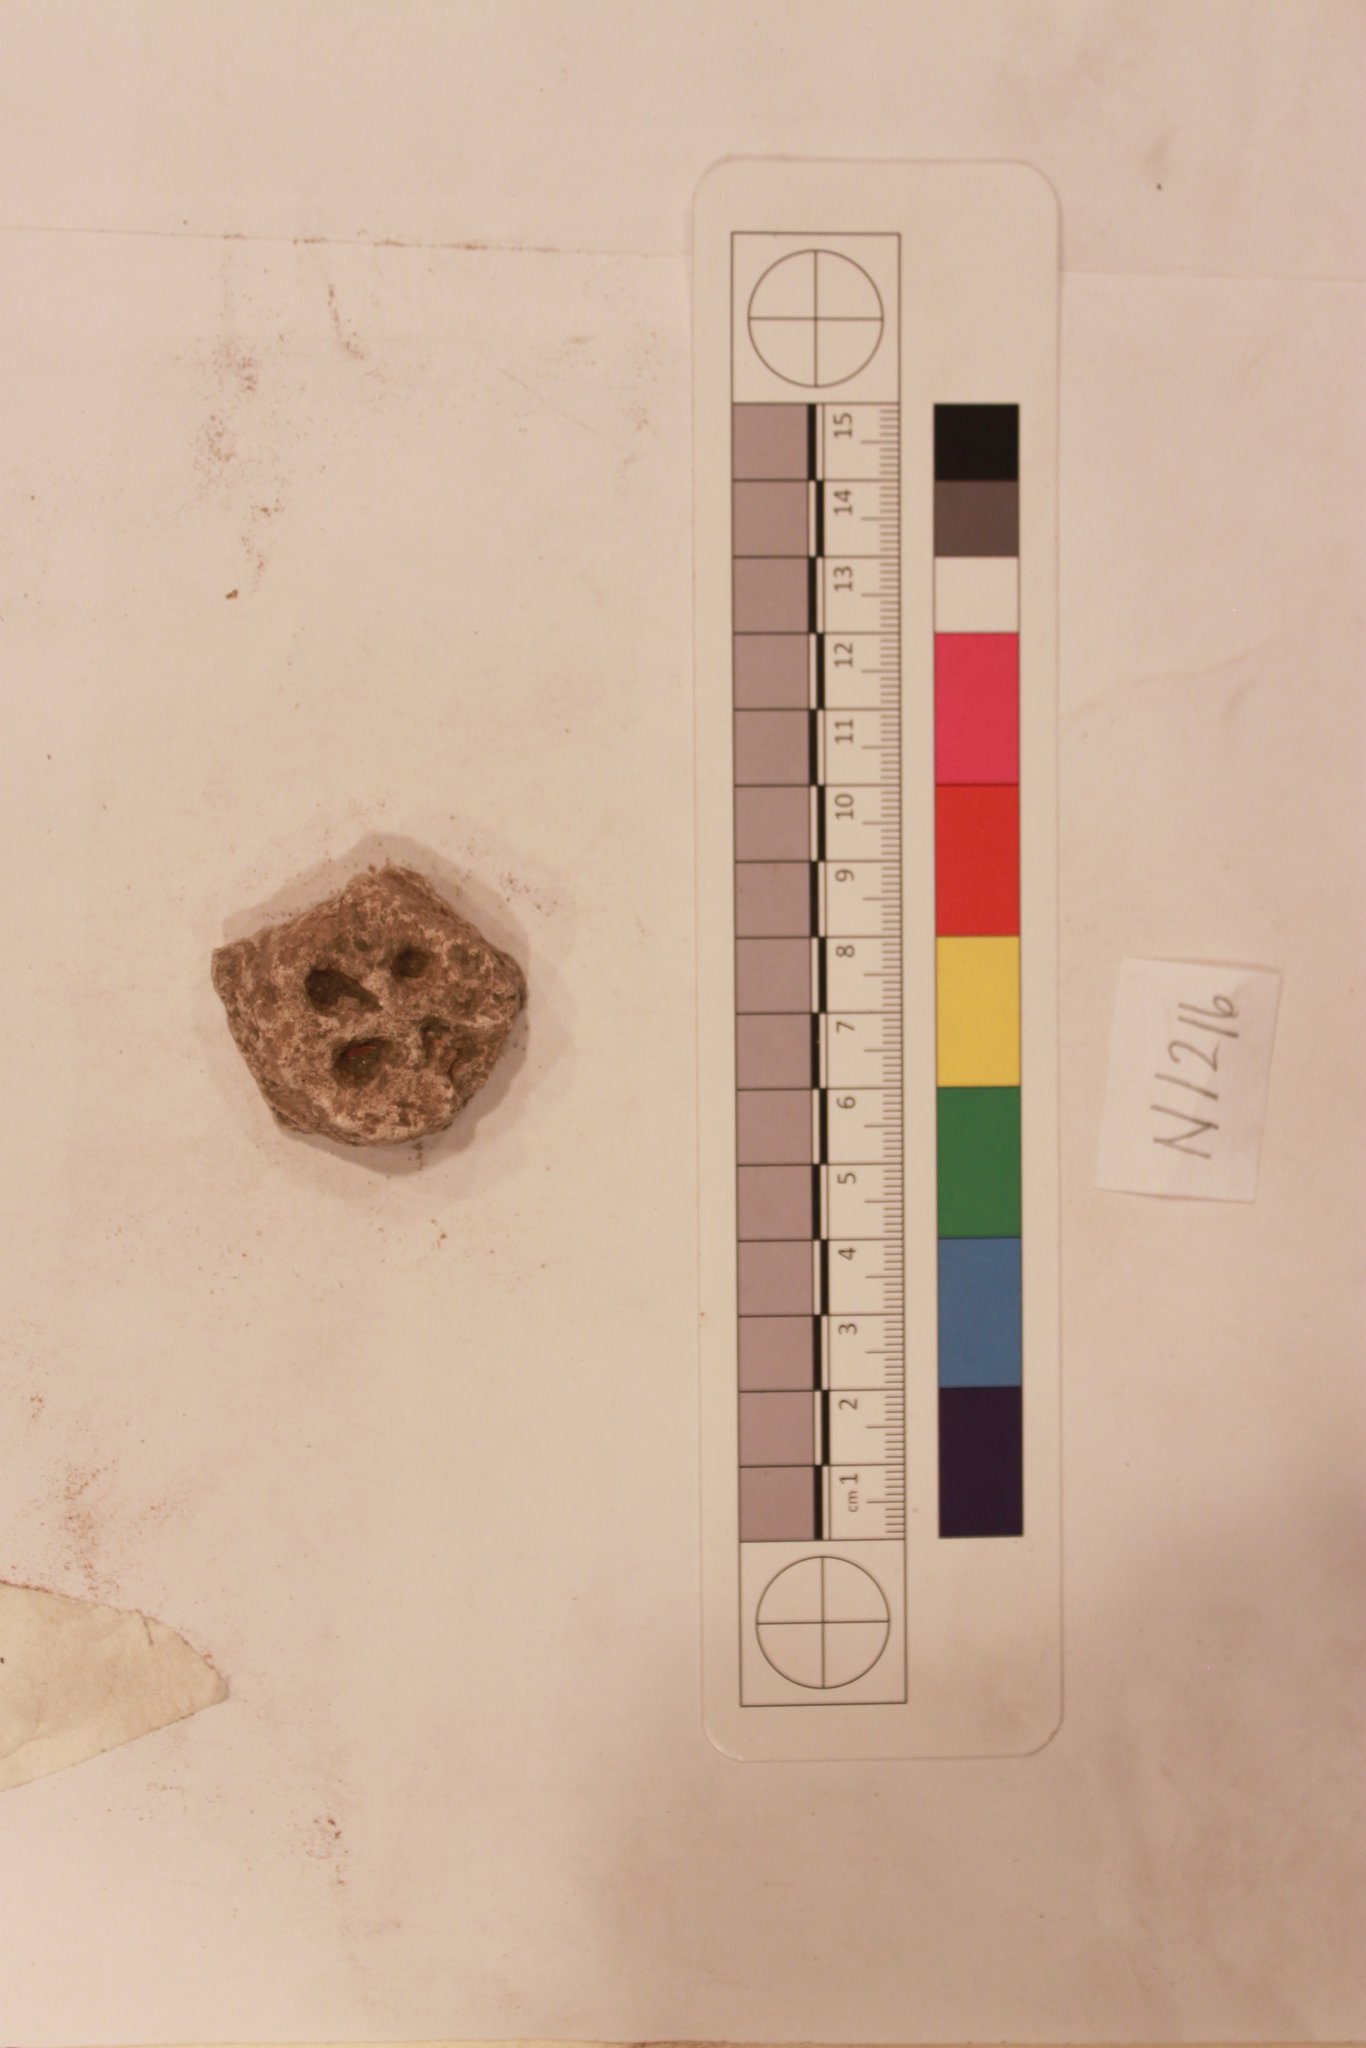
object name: fragment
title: Stucco Fragment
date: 701-1200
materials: plaster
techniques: carving, painting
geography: iran